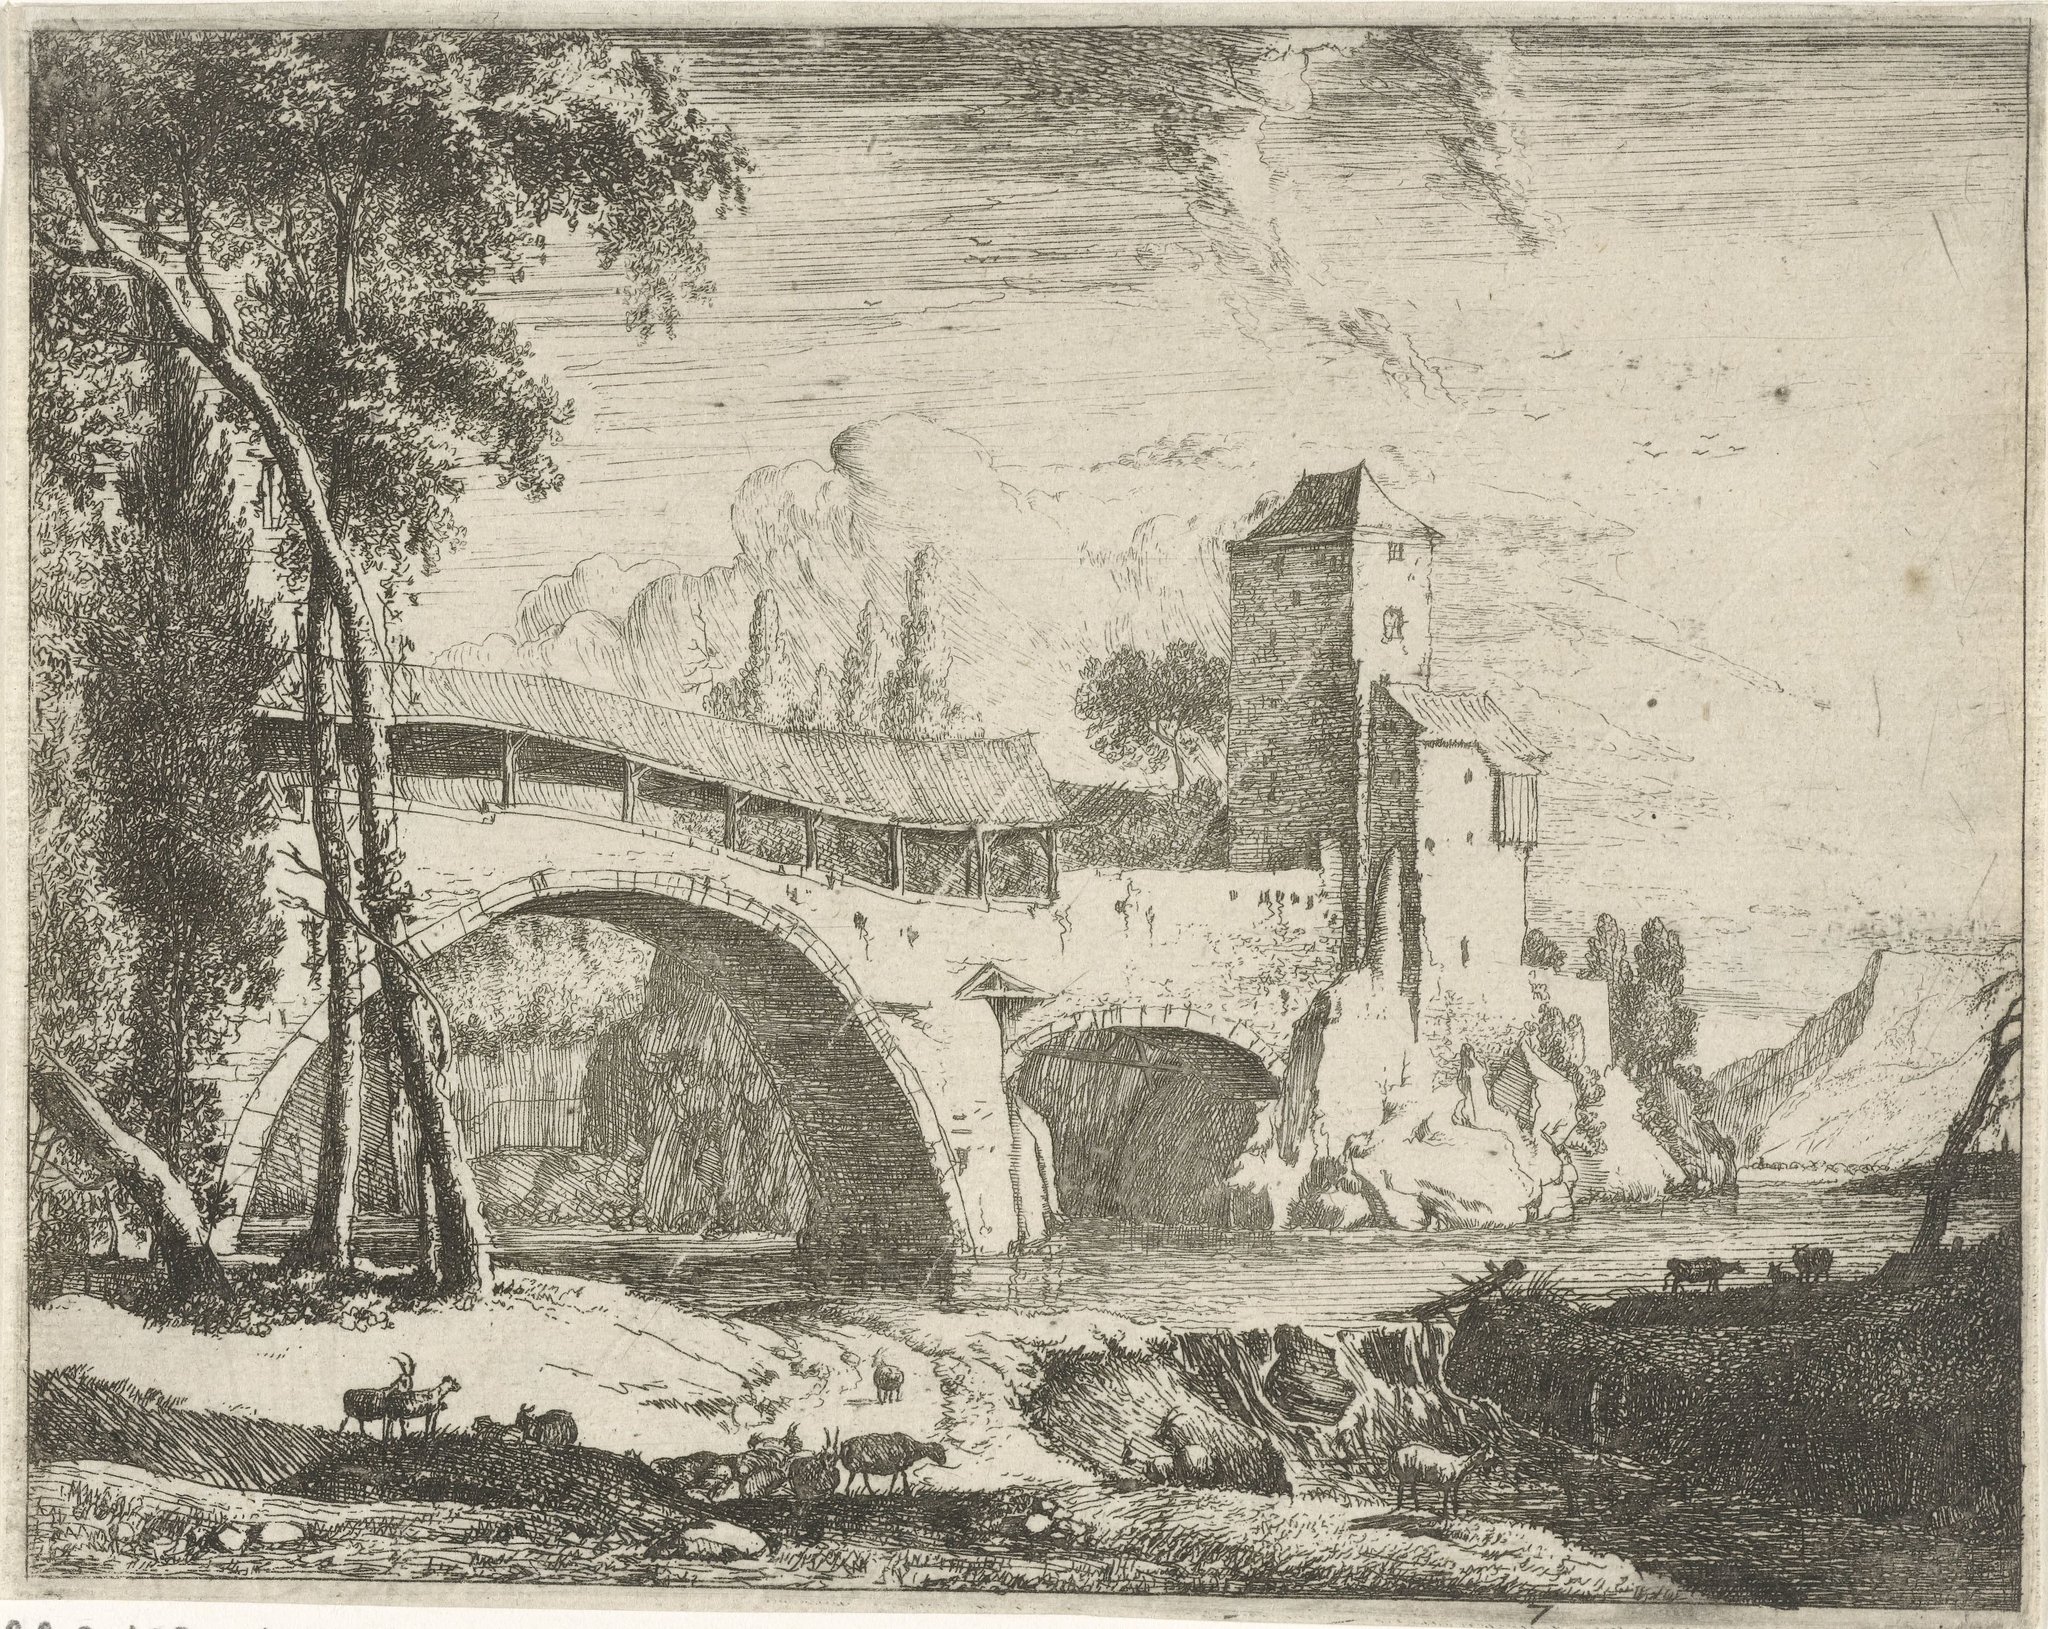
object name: print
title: Tiroolse landschappen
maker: roelant roghman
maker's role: draughtsman, painter, print maker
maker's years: 1627-1692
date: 1637-1692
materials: paper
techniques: etching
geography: amsterdam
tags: river, landscape with bridge, viaduct or aqueduct, tower (of house or building), herd, flock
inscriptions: collector's mark: Lugt 2228a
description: Gezicht op een brug met een toren. Op de voorgrond, bij een rivier, een groep geiten en schapen. Prent uit een serie van acht prenten met Tiroolse landschappen.